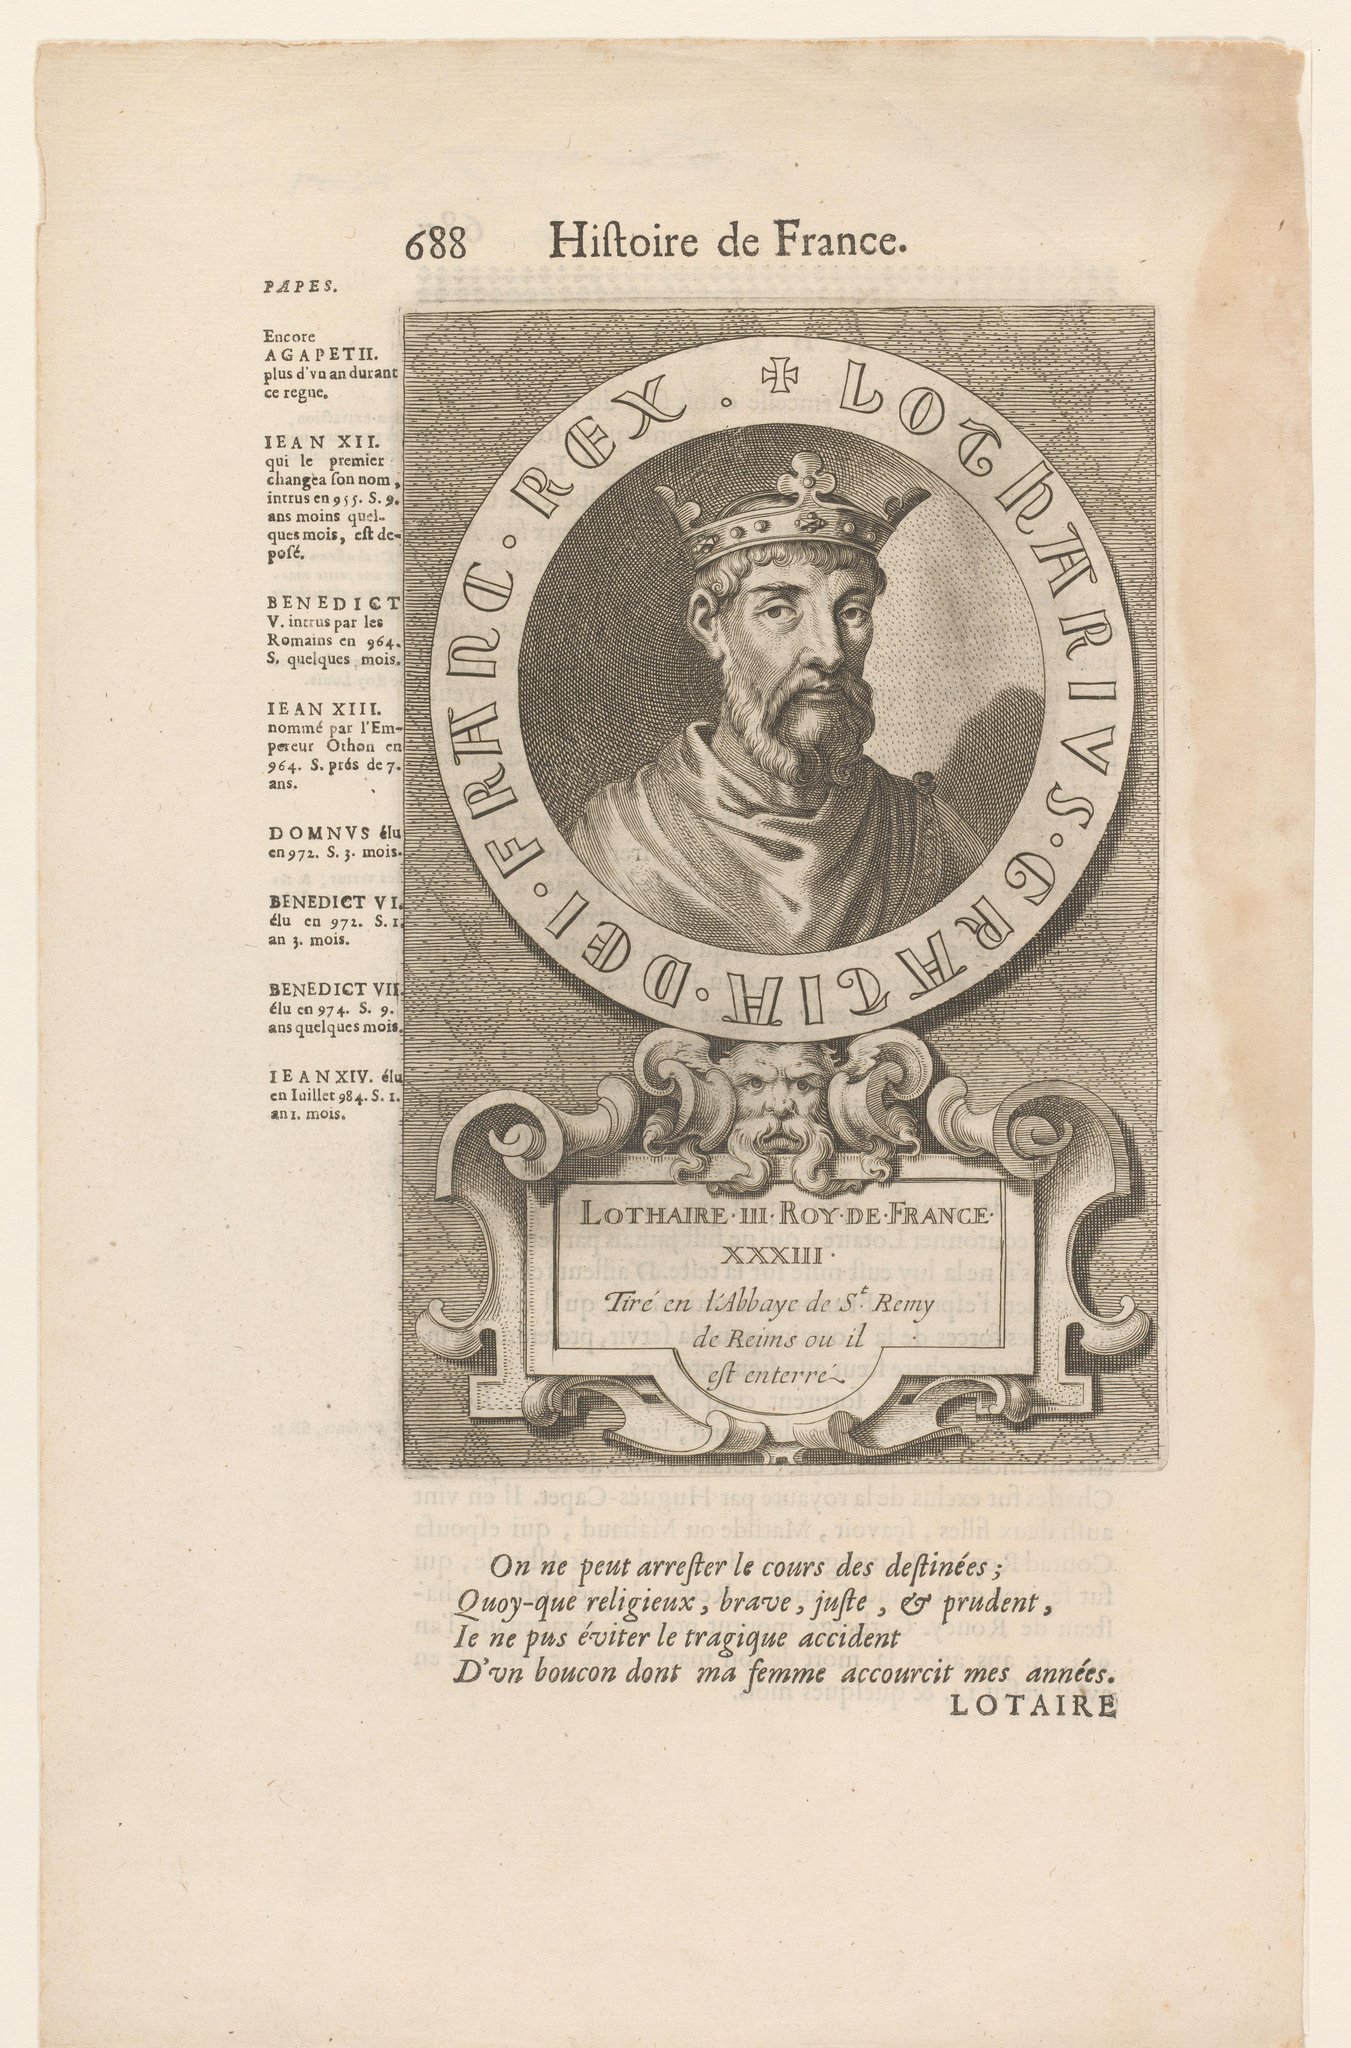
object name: print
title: Portret van Lotharius van Frankrijk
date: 1685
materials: paper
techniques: engraving, letterpress printing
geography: paris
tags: historical persons, king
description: Prent uit: Mézeray, François Eudes de. Histoire de France, depuis Faramond jusqu'au regne de Louis le Juste. (...) Parijs: Denis Thierry, Jean Guignard en Claude Barbin, 1685, dl. 1, p. 688.